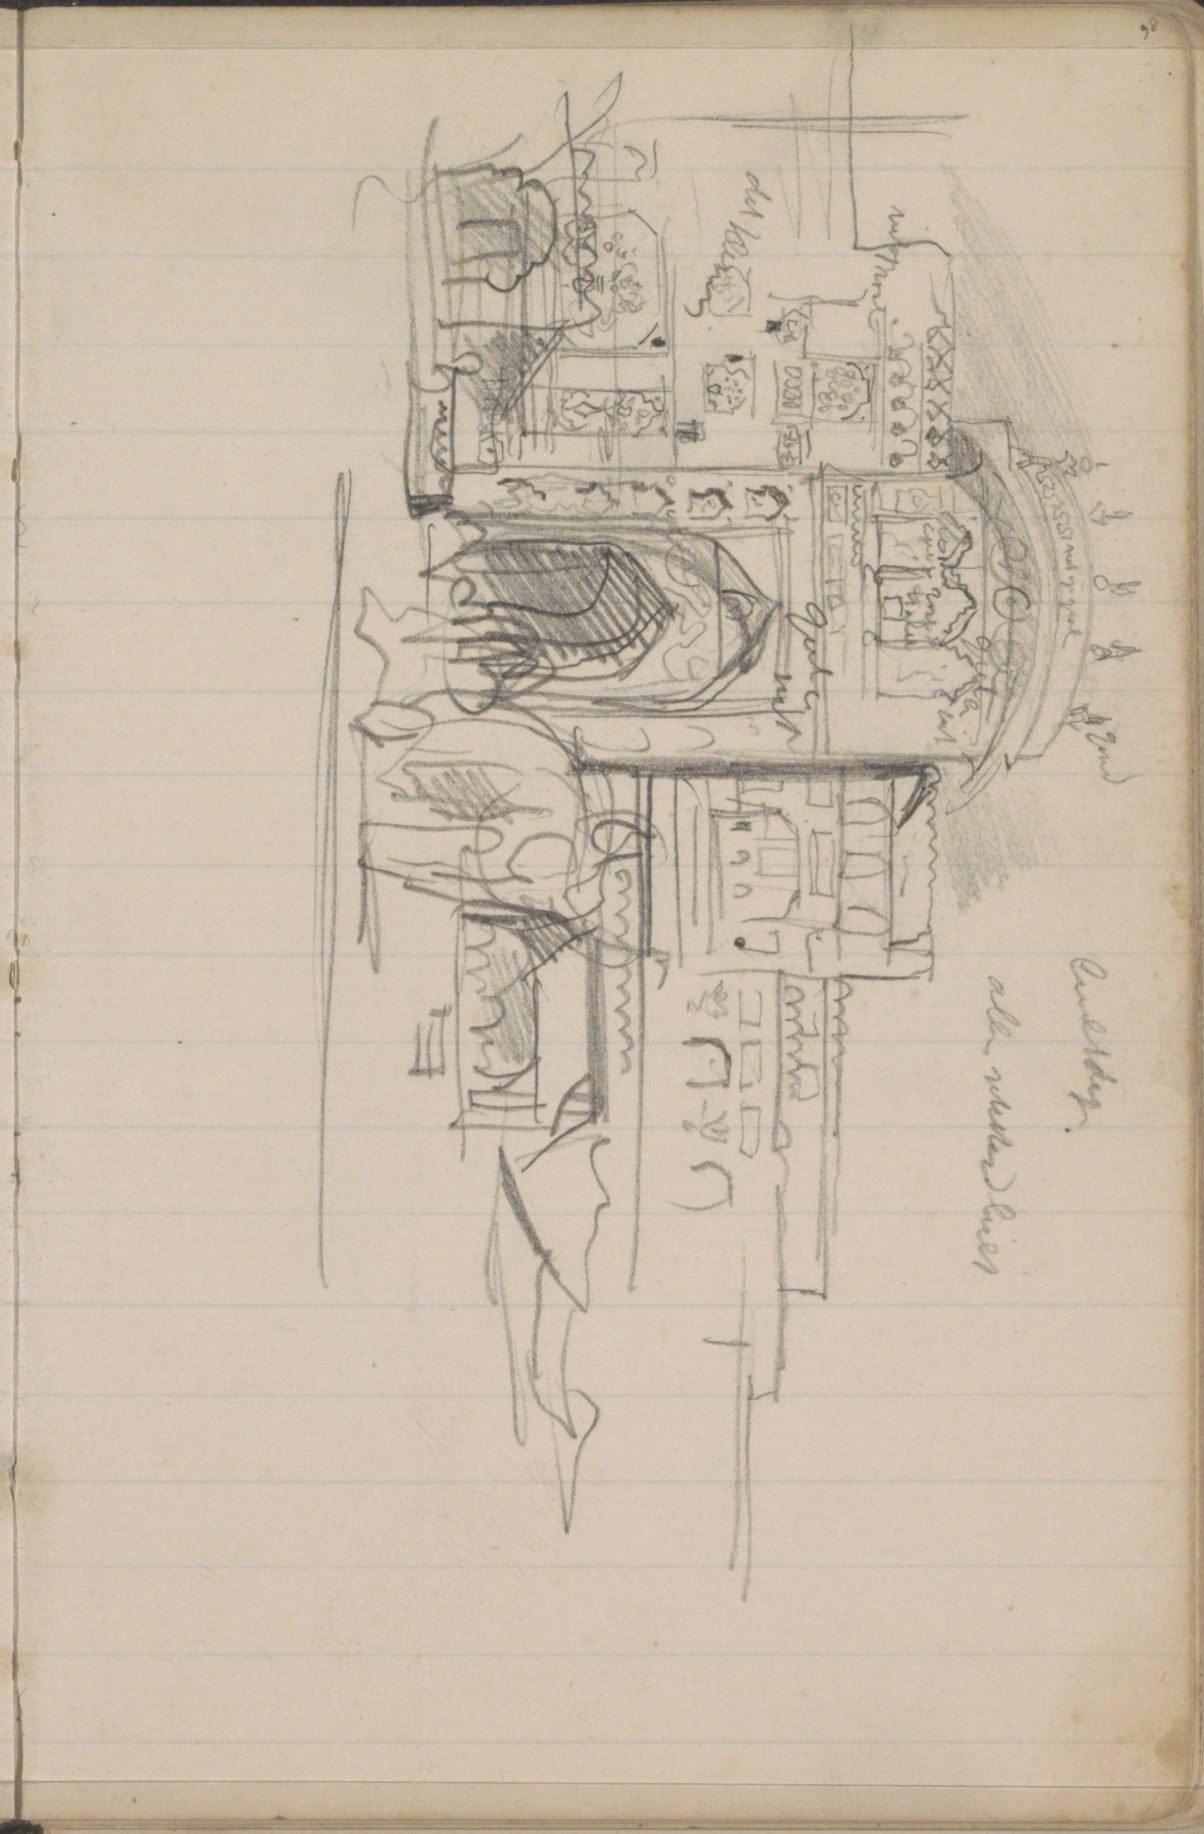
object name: sketchbook leaf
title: Olifant bij het portaal van een gebouw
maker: marius bauer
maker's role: draughtsman, print maker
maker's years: 1867-1932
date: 1897-1898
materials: pencil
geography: india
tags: arch, archivolt ~ architecture, architecture, trunked animals: elephant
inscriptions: kleurnotitie, handgeschreven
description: Pagina 98 uit een schetsboek met 84 bladen.